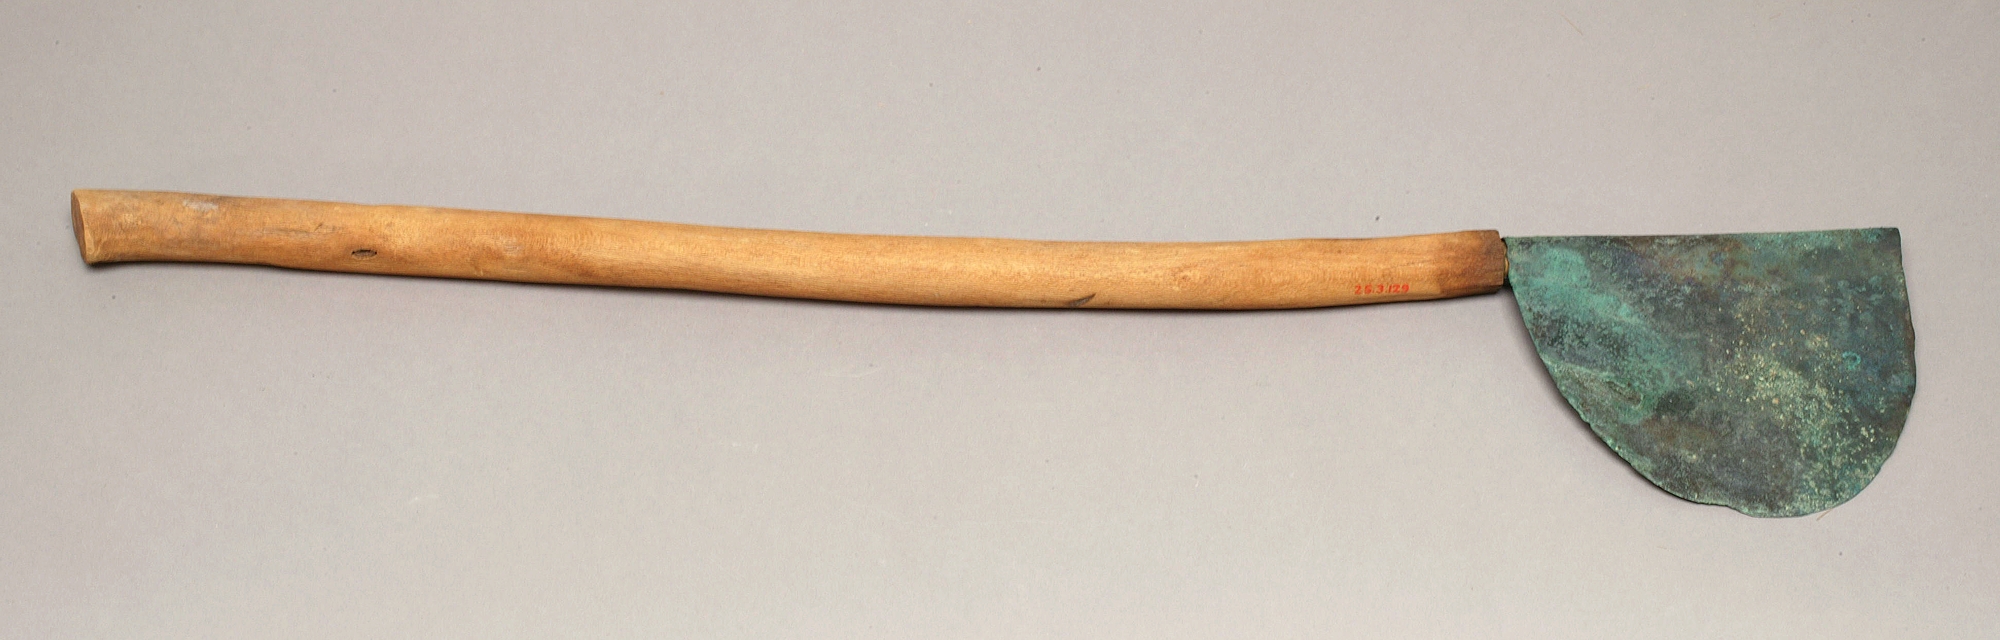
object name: ax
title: Ax From a Foundation Deposit, Hatshepsut's Temple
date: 1479-1458 BCE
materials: bronze, copper alloy, wood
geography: egypt